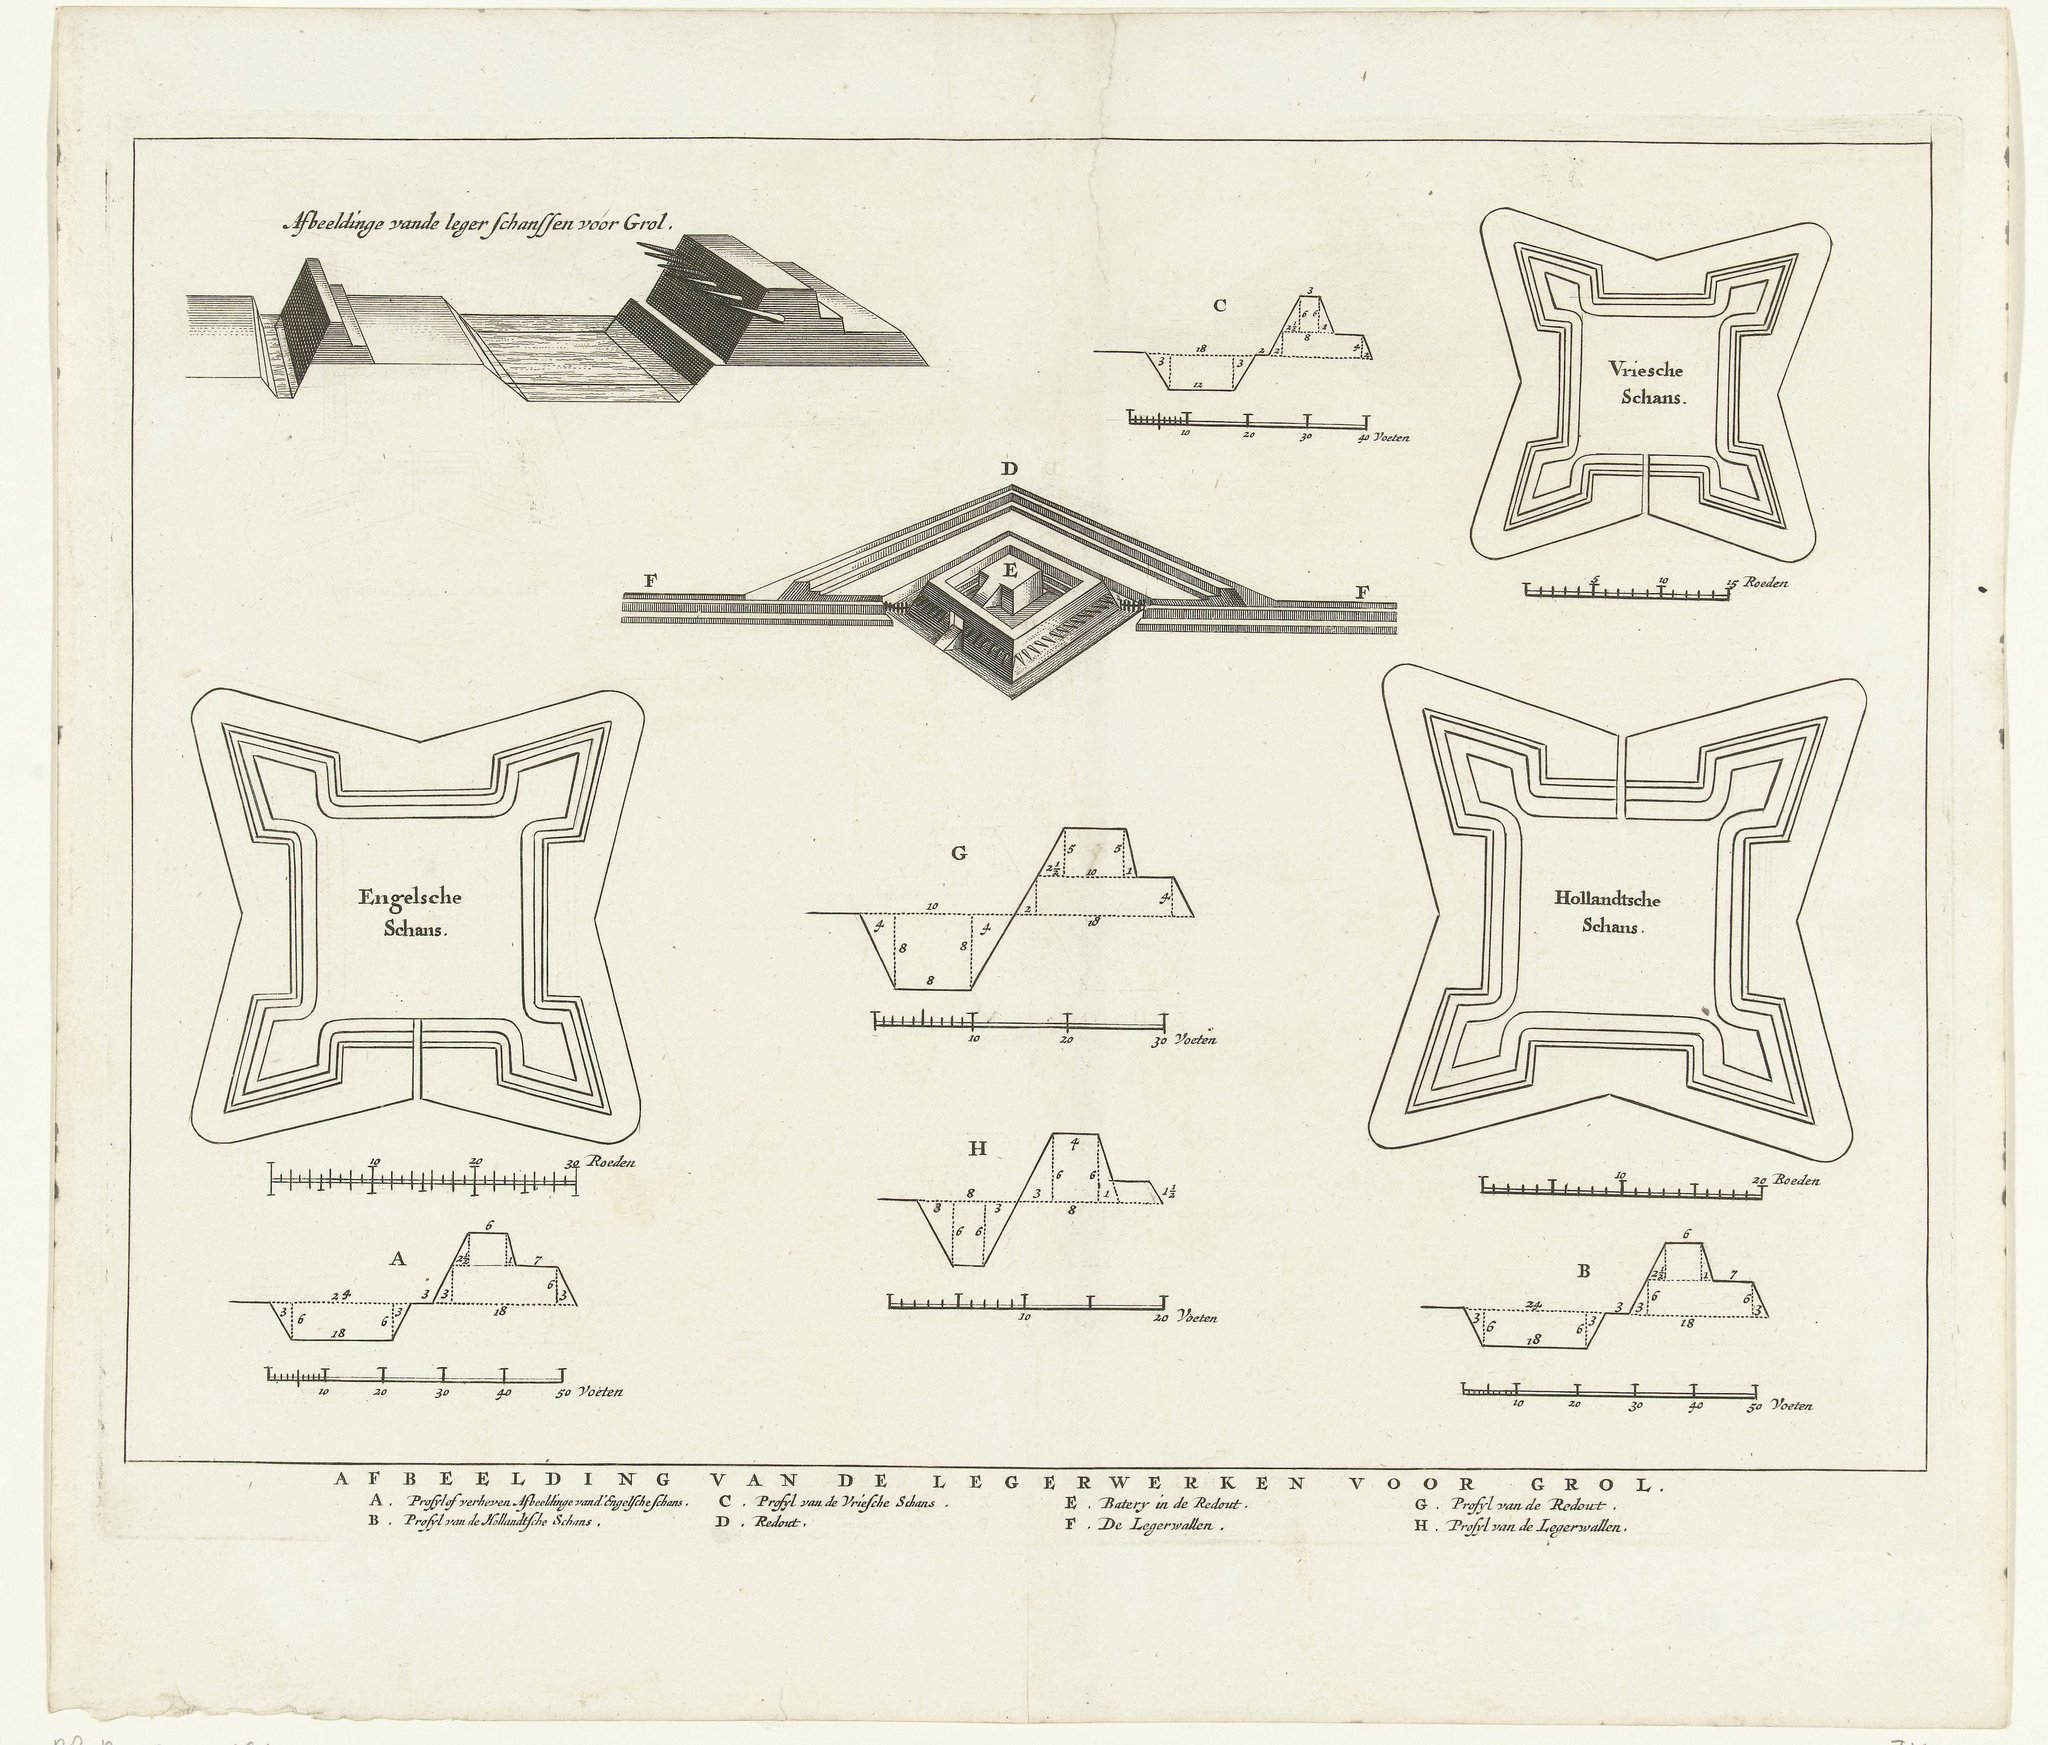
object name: history print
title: Afbeelding van de legerwerken voor Grol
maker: Anonymous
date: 1649-1699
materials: paper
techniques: engraving, etching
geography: northern netherlands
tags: delft, the hague, frederick henry (prince of orange), fortifications, military engineering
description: Schema's, figuren en doorsneden van schansen voor Grol, bij het beleg en verovering van de stad Groenlo (Grol) door het Staatse leger onder Frederik Hendrik, 6 juli - 19 augustus 1627. Links- en rechtsonder een schaalstok: Voeten.